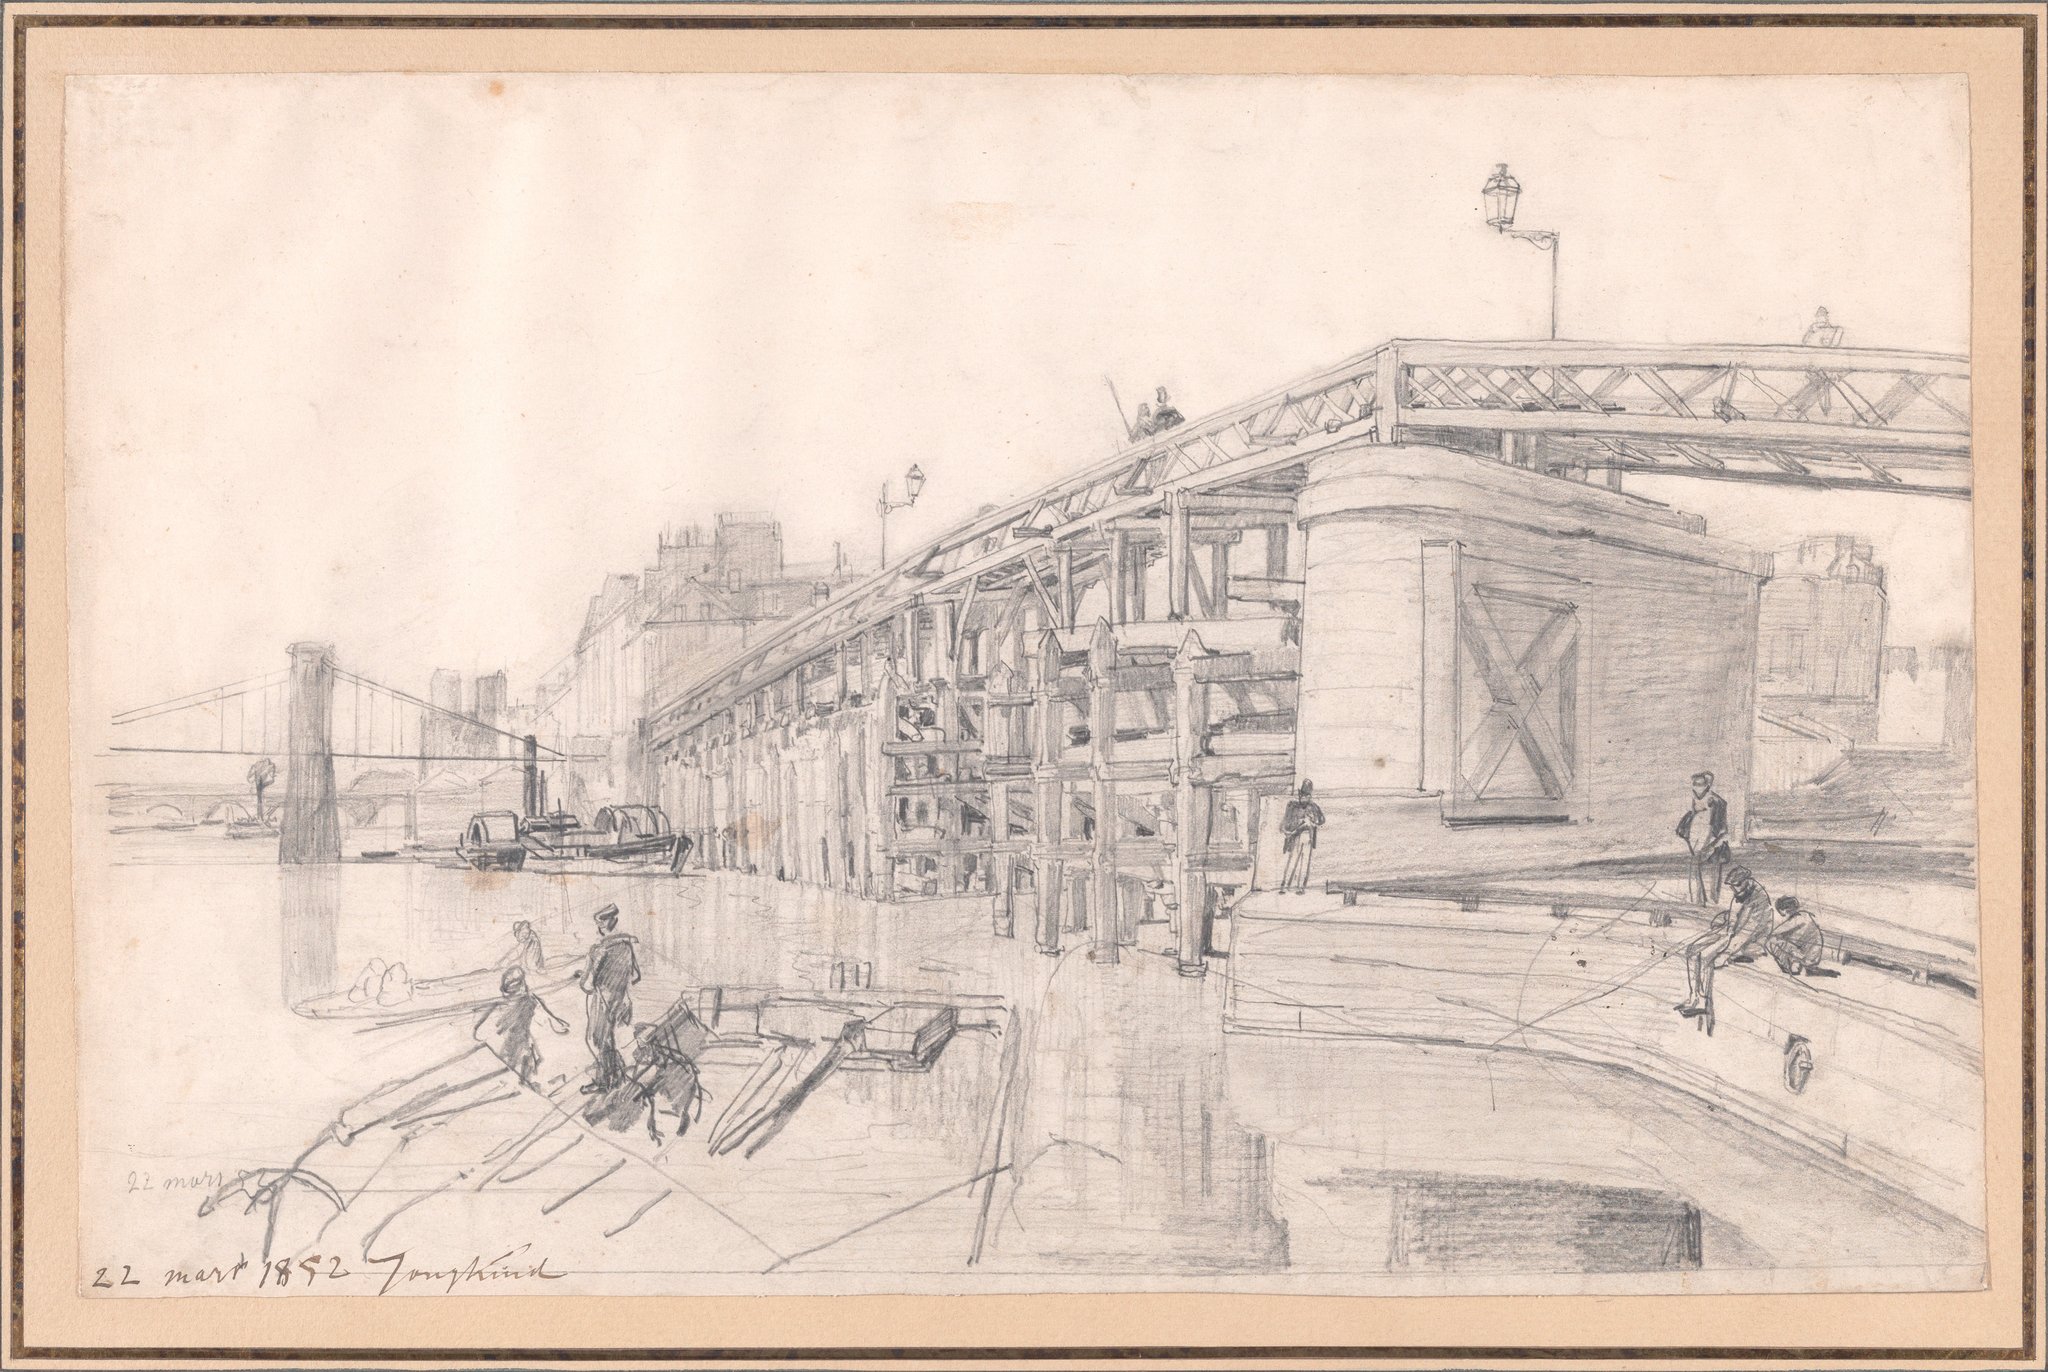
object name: drawing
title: L'Estacade à Paris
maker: johan barthold jongkind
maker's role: artist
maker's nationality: dutch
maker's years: 1819-1891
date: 1852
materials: graphite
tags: bridges,paris